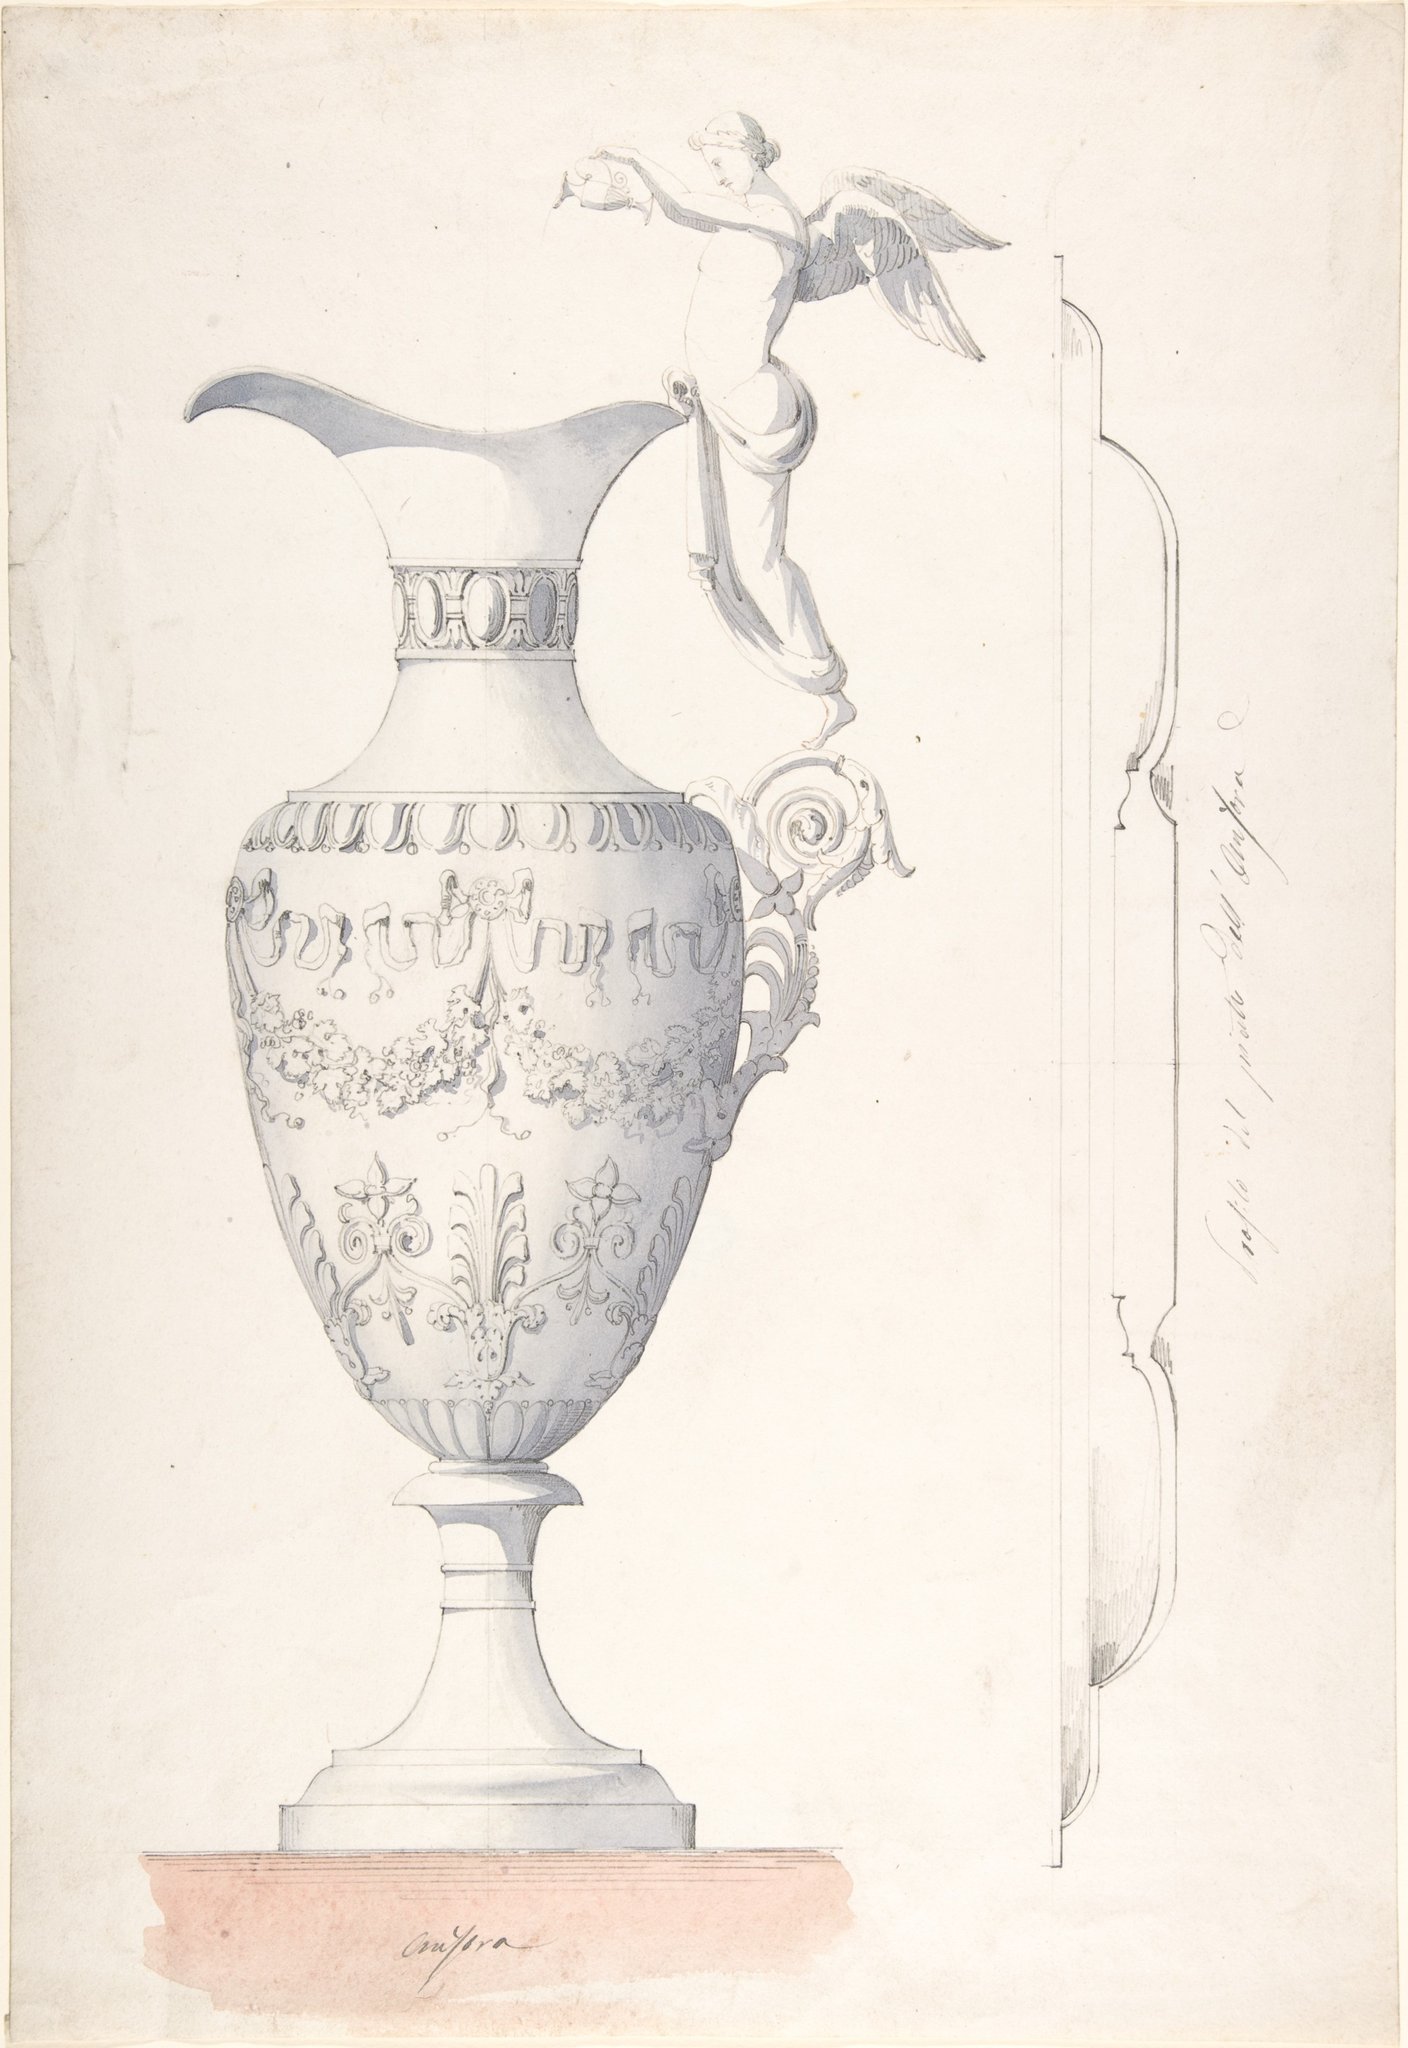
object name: drawing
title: Ewer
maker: anonymous, italian, 19th century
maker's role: artist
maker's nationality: italian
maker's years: 1800-1900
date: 1800-1900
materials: ink, watercolor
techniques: pen, wash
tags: garlands,ewers